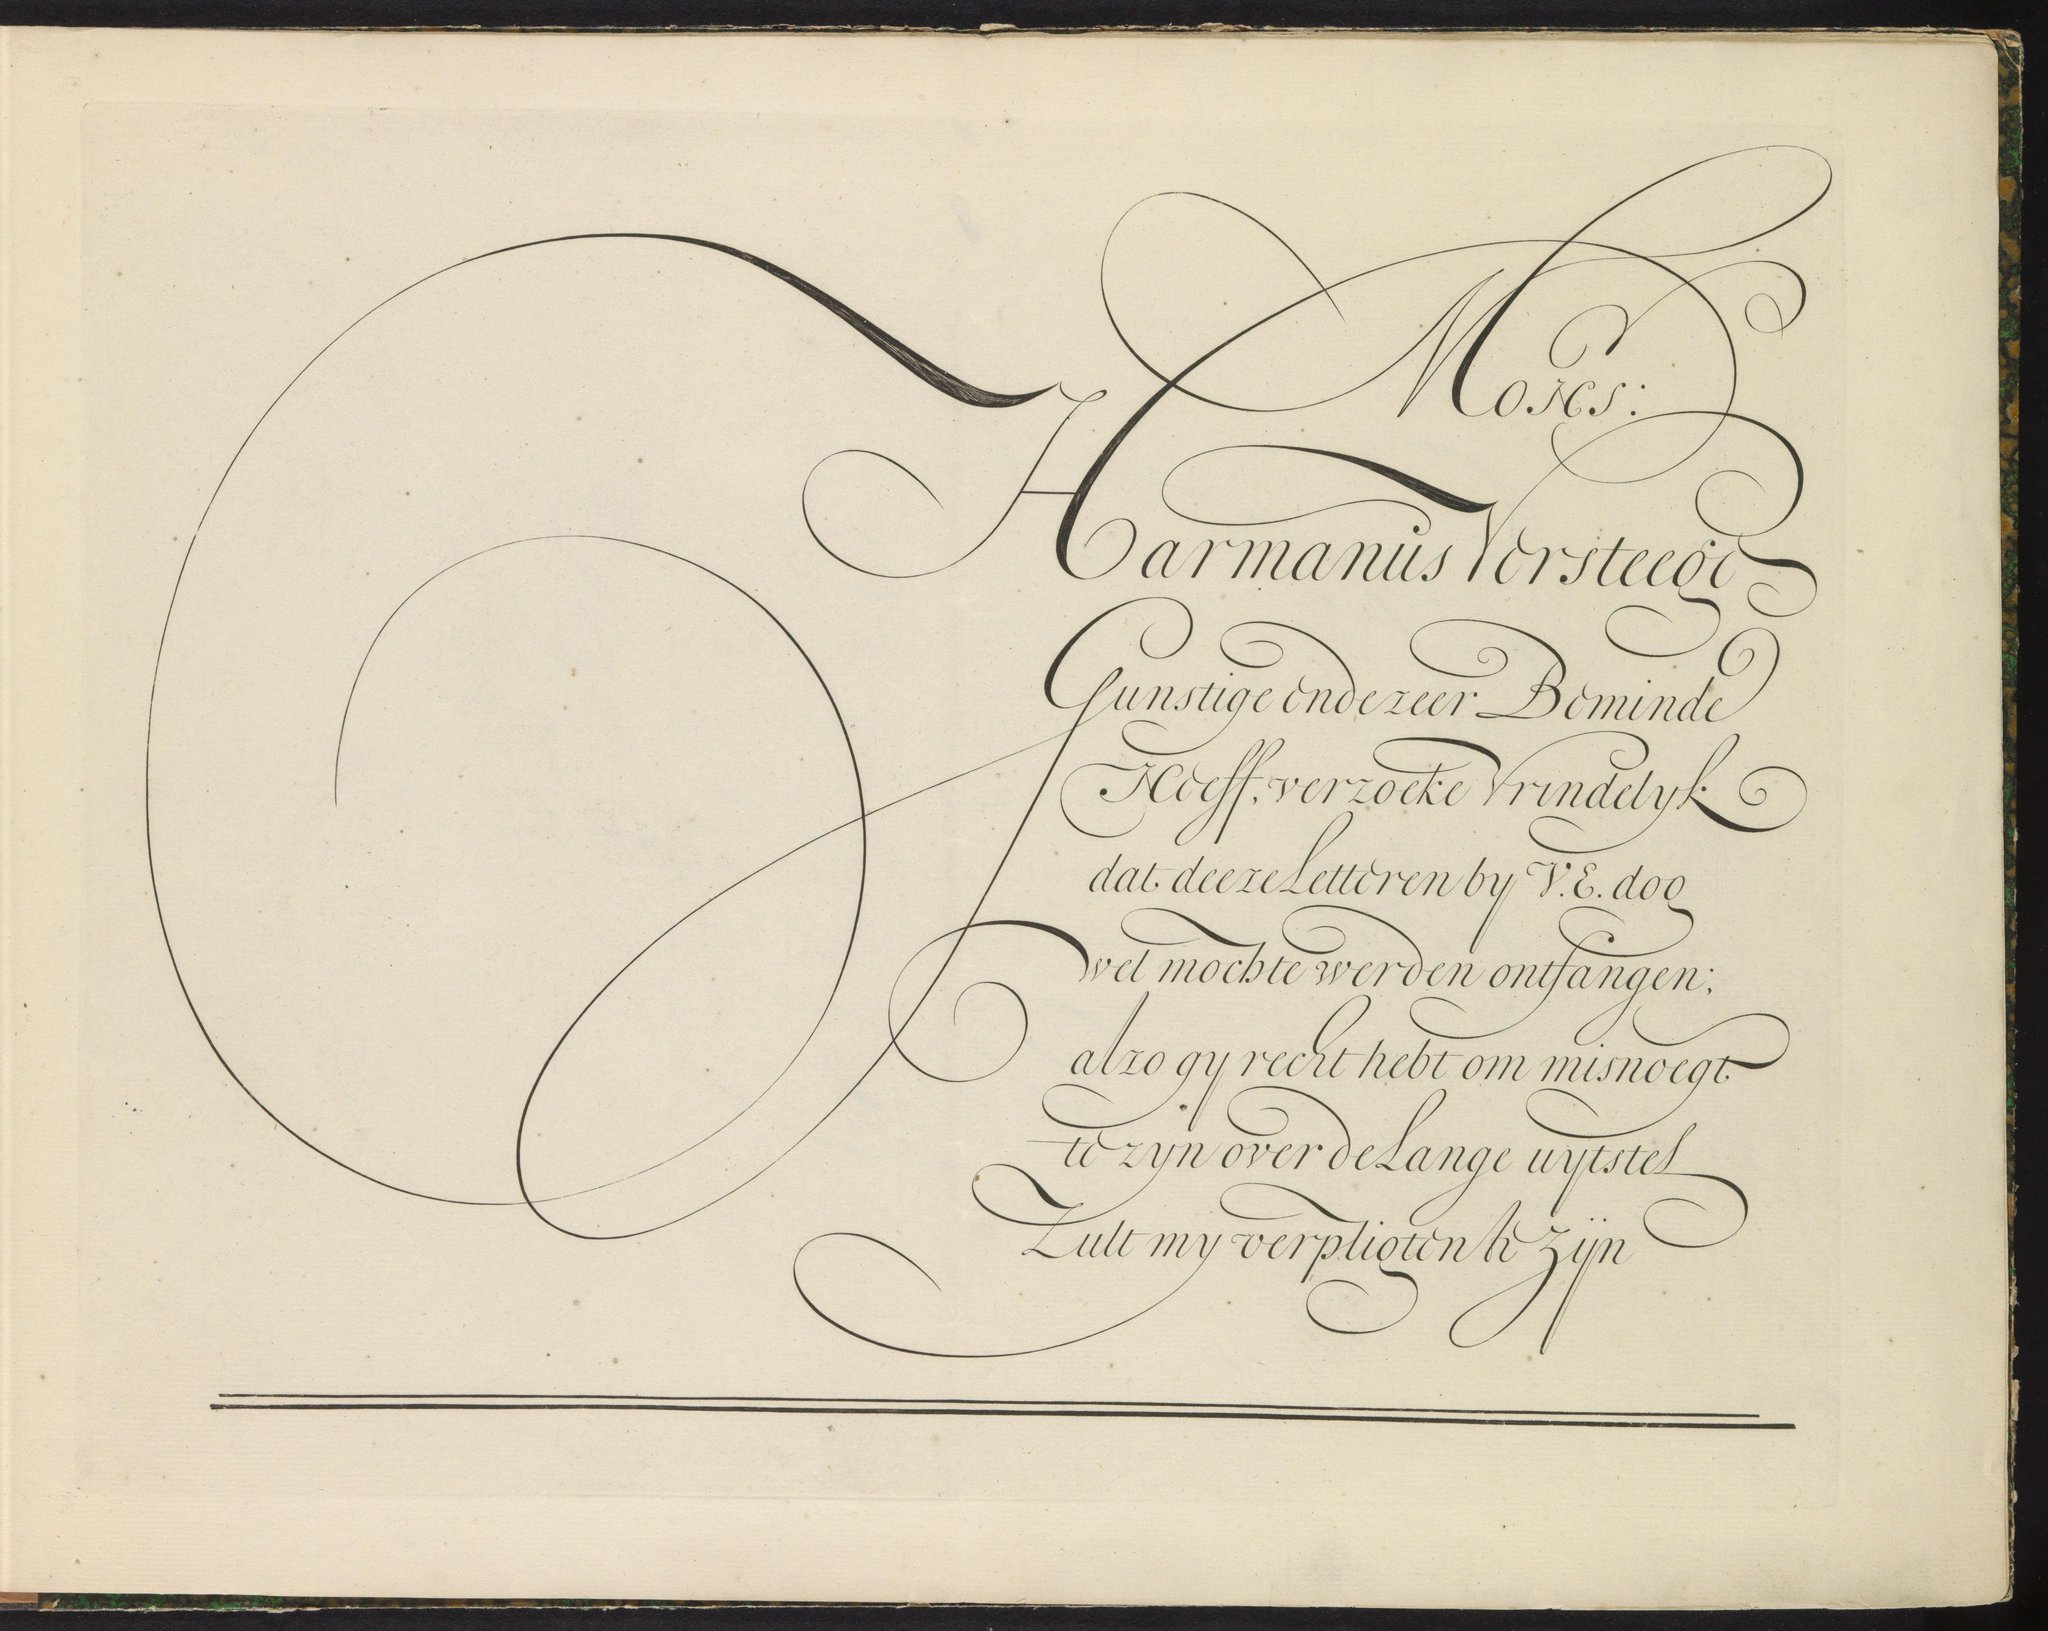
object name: album leaf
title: Schrijfvoorbeeld: Mons(ieur) Harmanus Versteege (...)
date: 1667-1718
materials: paper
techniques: engraving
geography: amsterdam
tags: calligraphy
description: Schrijfvoorbeeld met negen regels tekst in het Nederlands: Mons(ieur) Harmanus Versteege Gunstige ensezeer Beminde Neeff ... De prent maakt deel uit van een album.